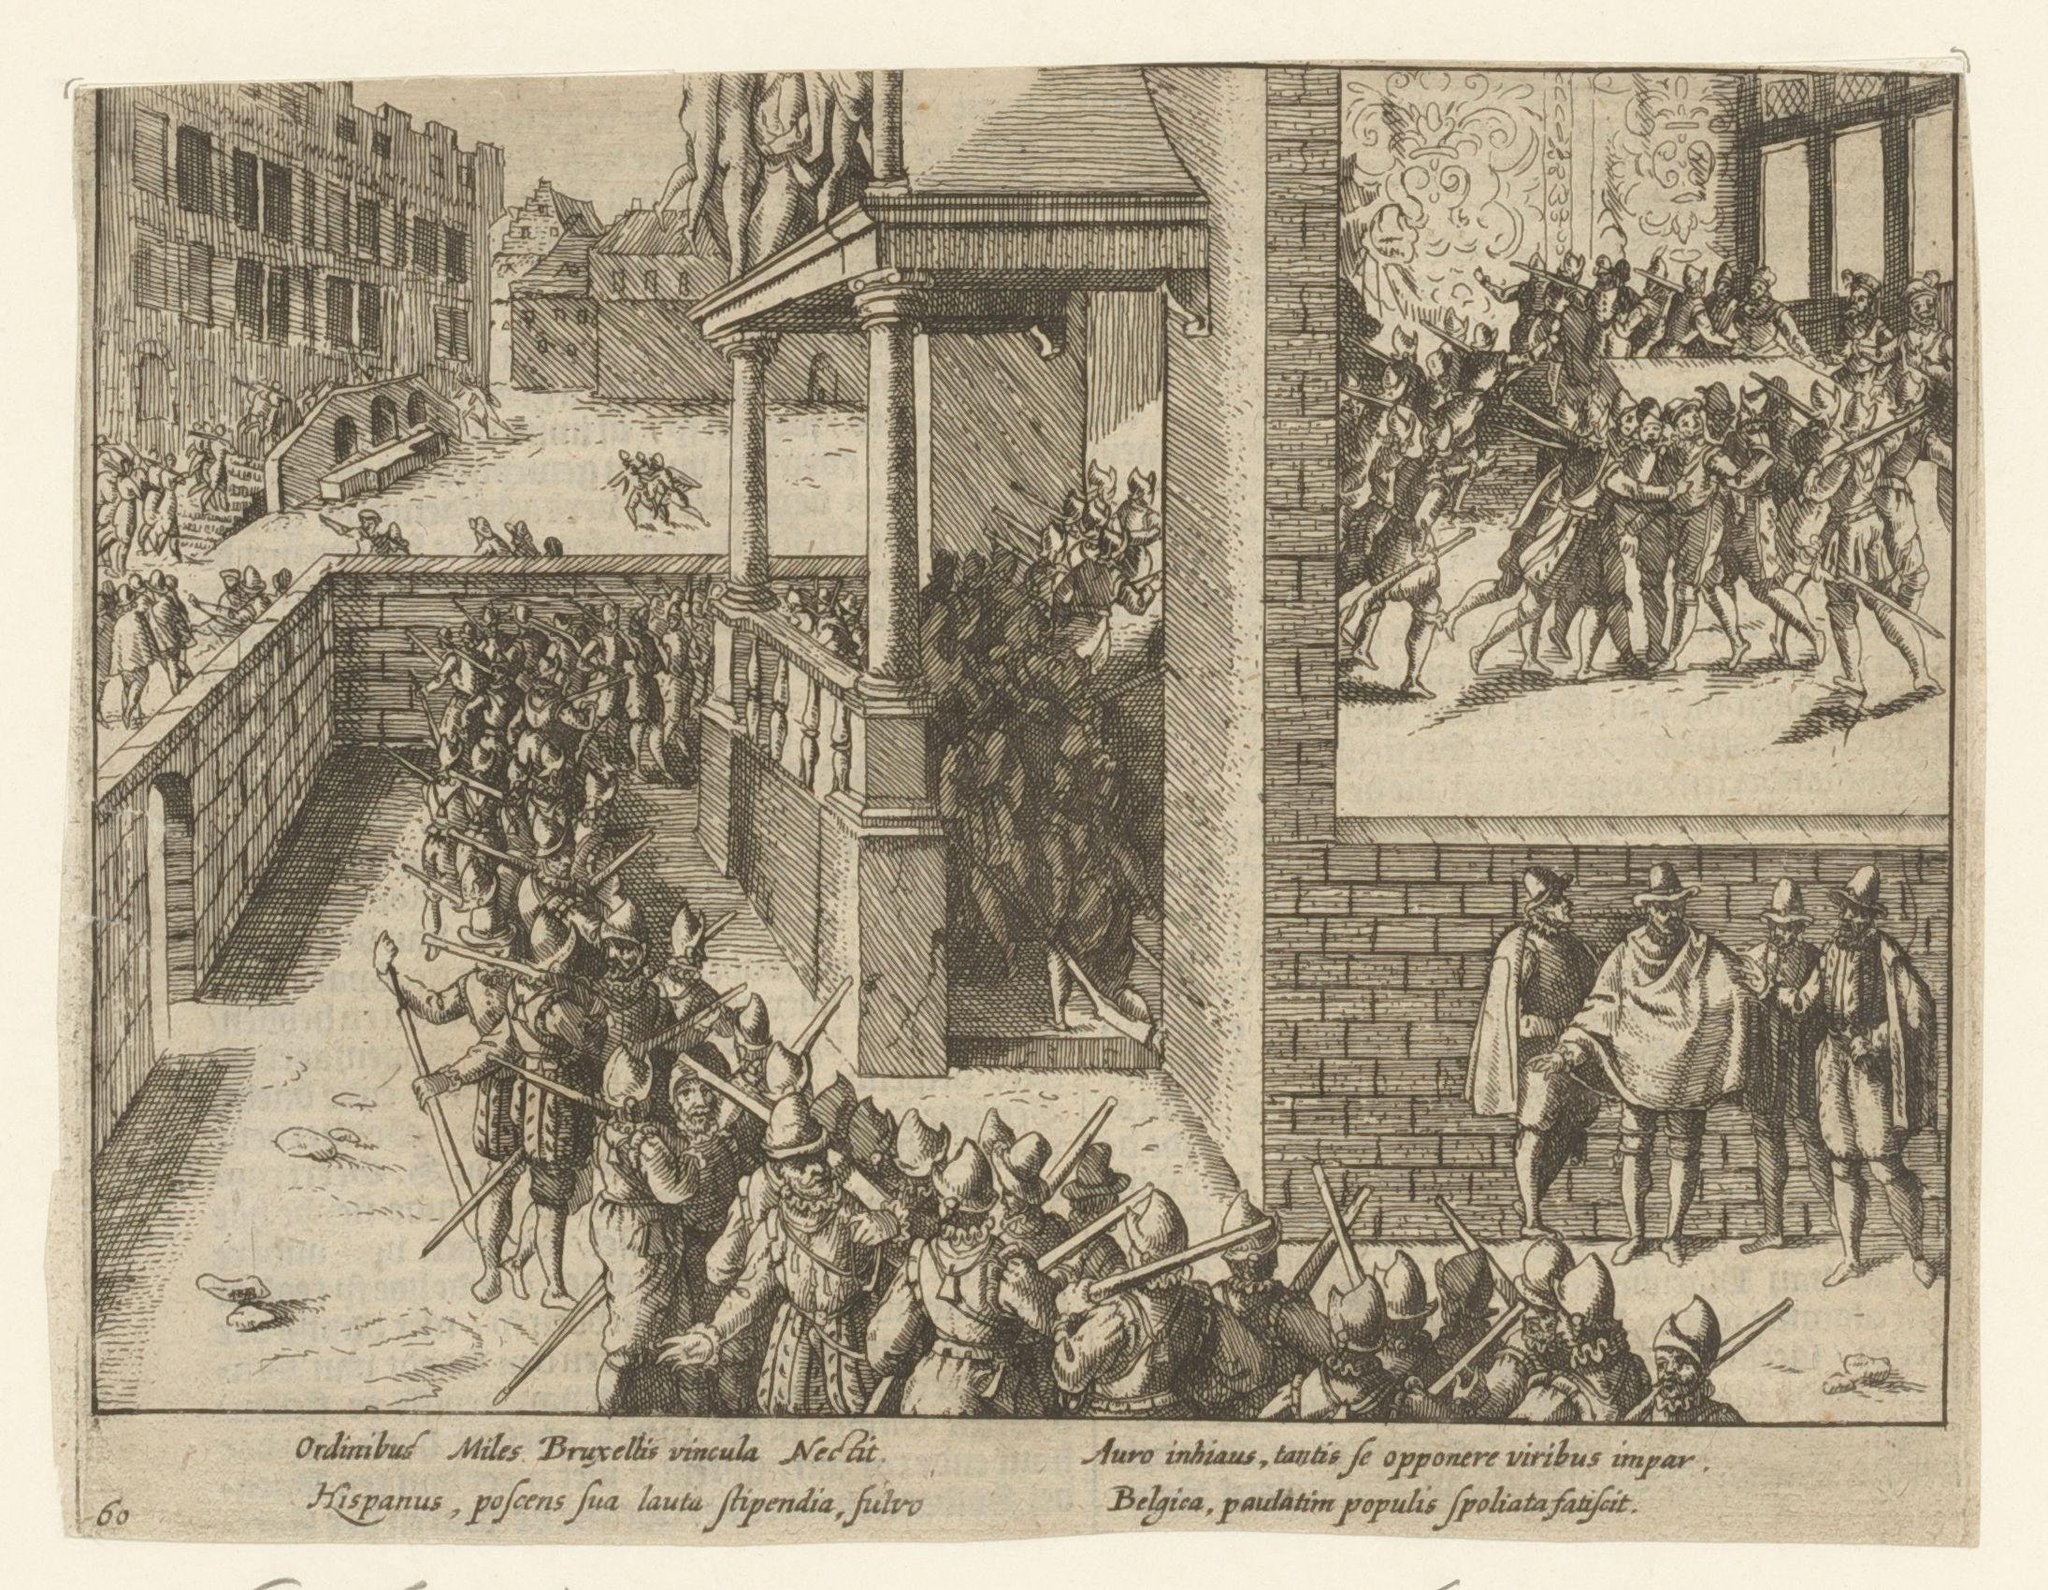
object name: book illustration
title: Leden van de Raad van State gevangengenomen, 1576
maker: Anonymous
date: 1613-1615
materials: paper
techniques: etching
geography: northern netherlands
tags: charles de berlaymont, bruges, brussels, clergyman, criminal law; punishment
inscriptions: collector's mark, collector's mark: Lugt 1641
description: De leden van de Spaansgezinde Raad van State worden in Brussel gevangengenomen, 5 september 1576. Soldaten overvallen het gebouw waar de Raad bijeen was. Boven worden Van Mansfeld, Berlaymont, Viglius en Del Rio gearresteerd. Met onderschrift van 4 regels in het Latijn. Genummerd: 60. Bedrukt op achterzijde met tekst in het Nederlands. Onderwerpsrubrieken binnen de Atlas Zeden en Gewoonten: Krijgswezen; prenten van Baudart. 80j. oorlog.